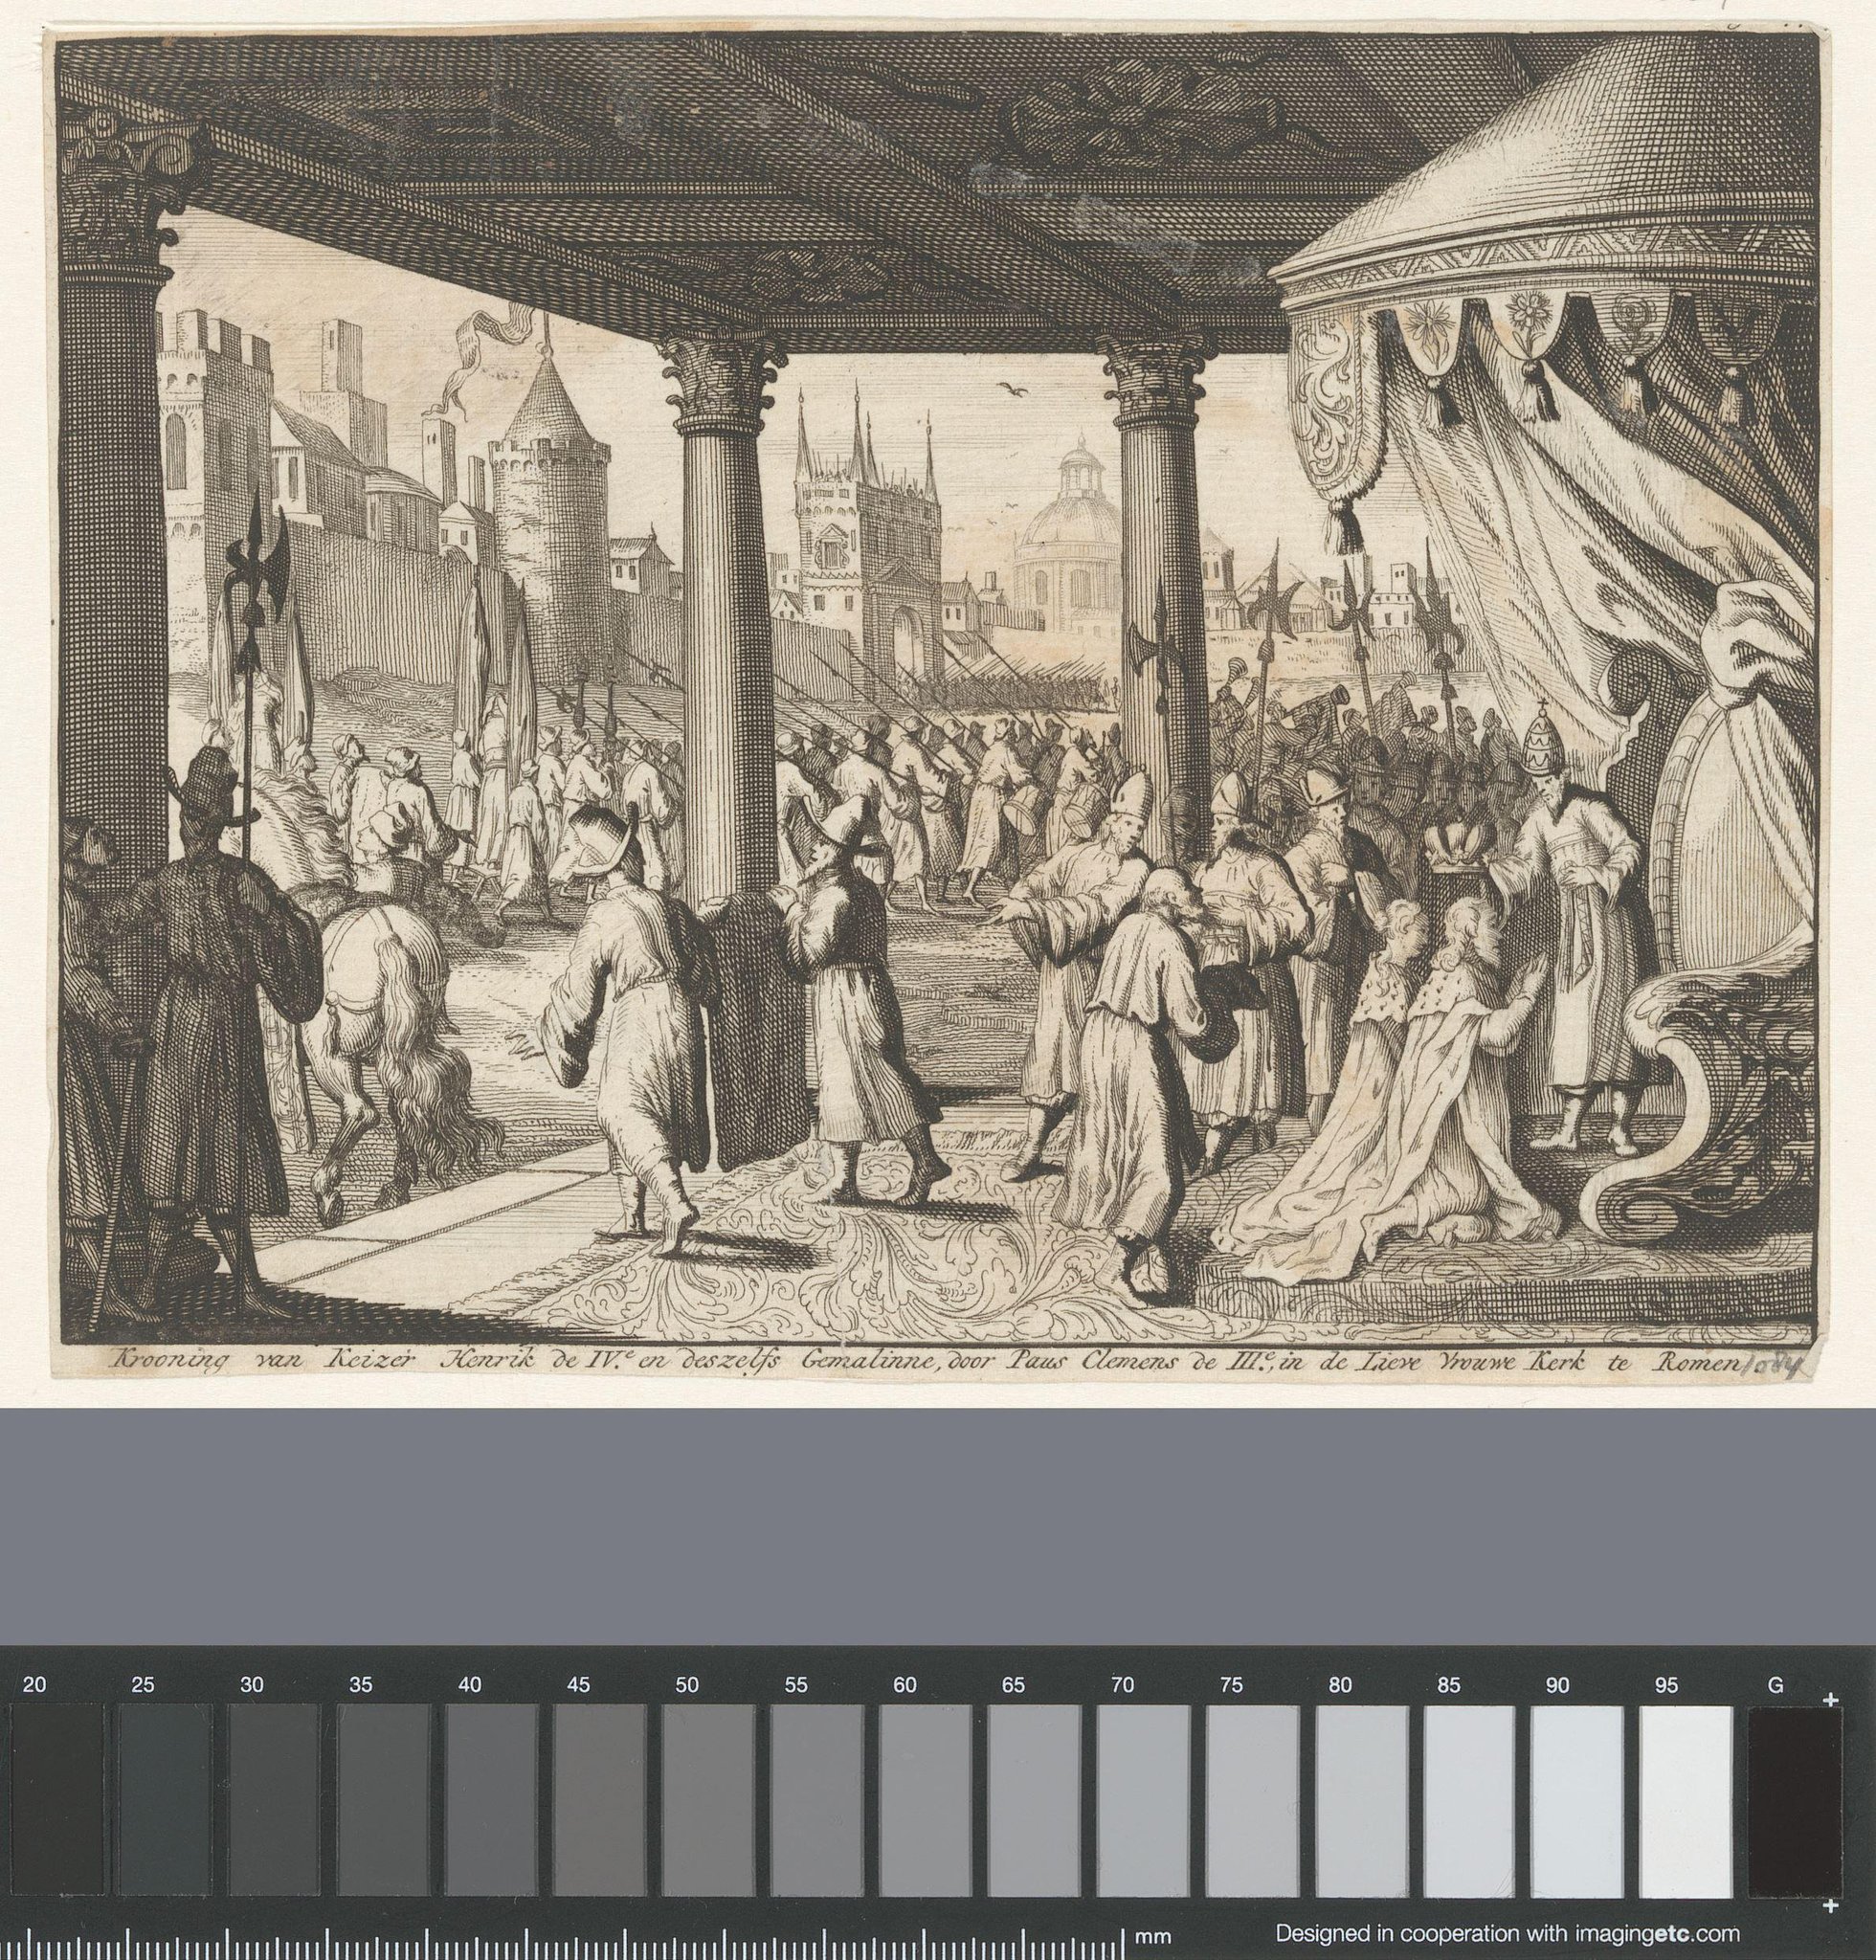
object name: print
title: Hendrik IV tot keizer gekroond, 1084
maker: Anonymous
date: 1650-1750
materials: paper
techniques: etching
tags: liège, during the coronation, rome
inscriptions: collector's mark: Lugt 2228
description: Na zijn verovering van Rome wordt Hendrik IV door tegenpaus Clemens III tot Rooms-Duits keizer gekroond, 31 maart 1084.